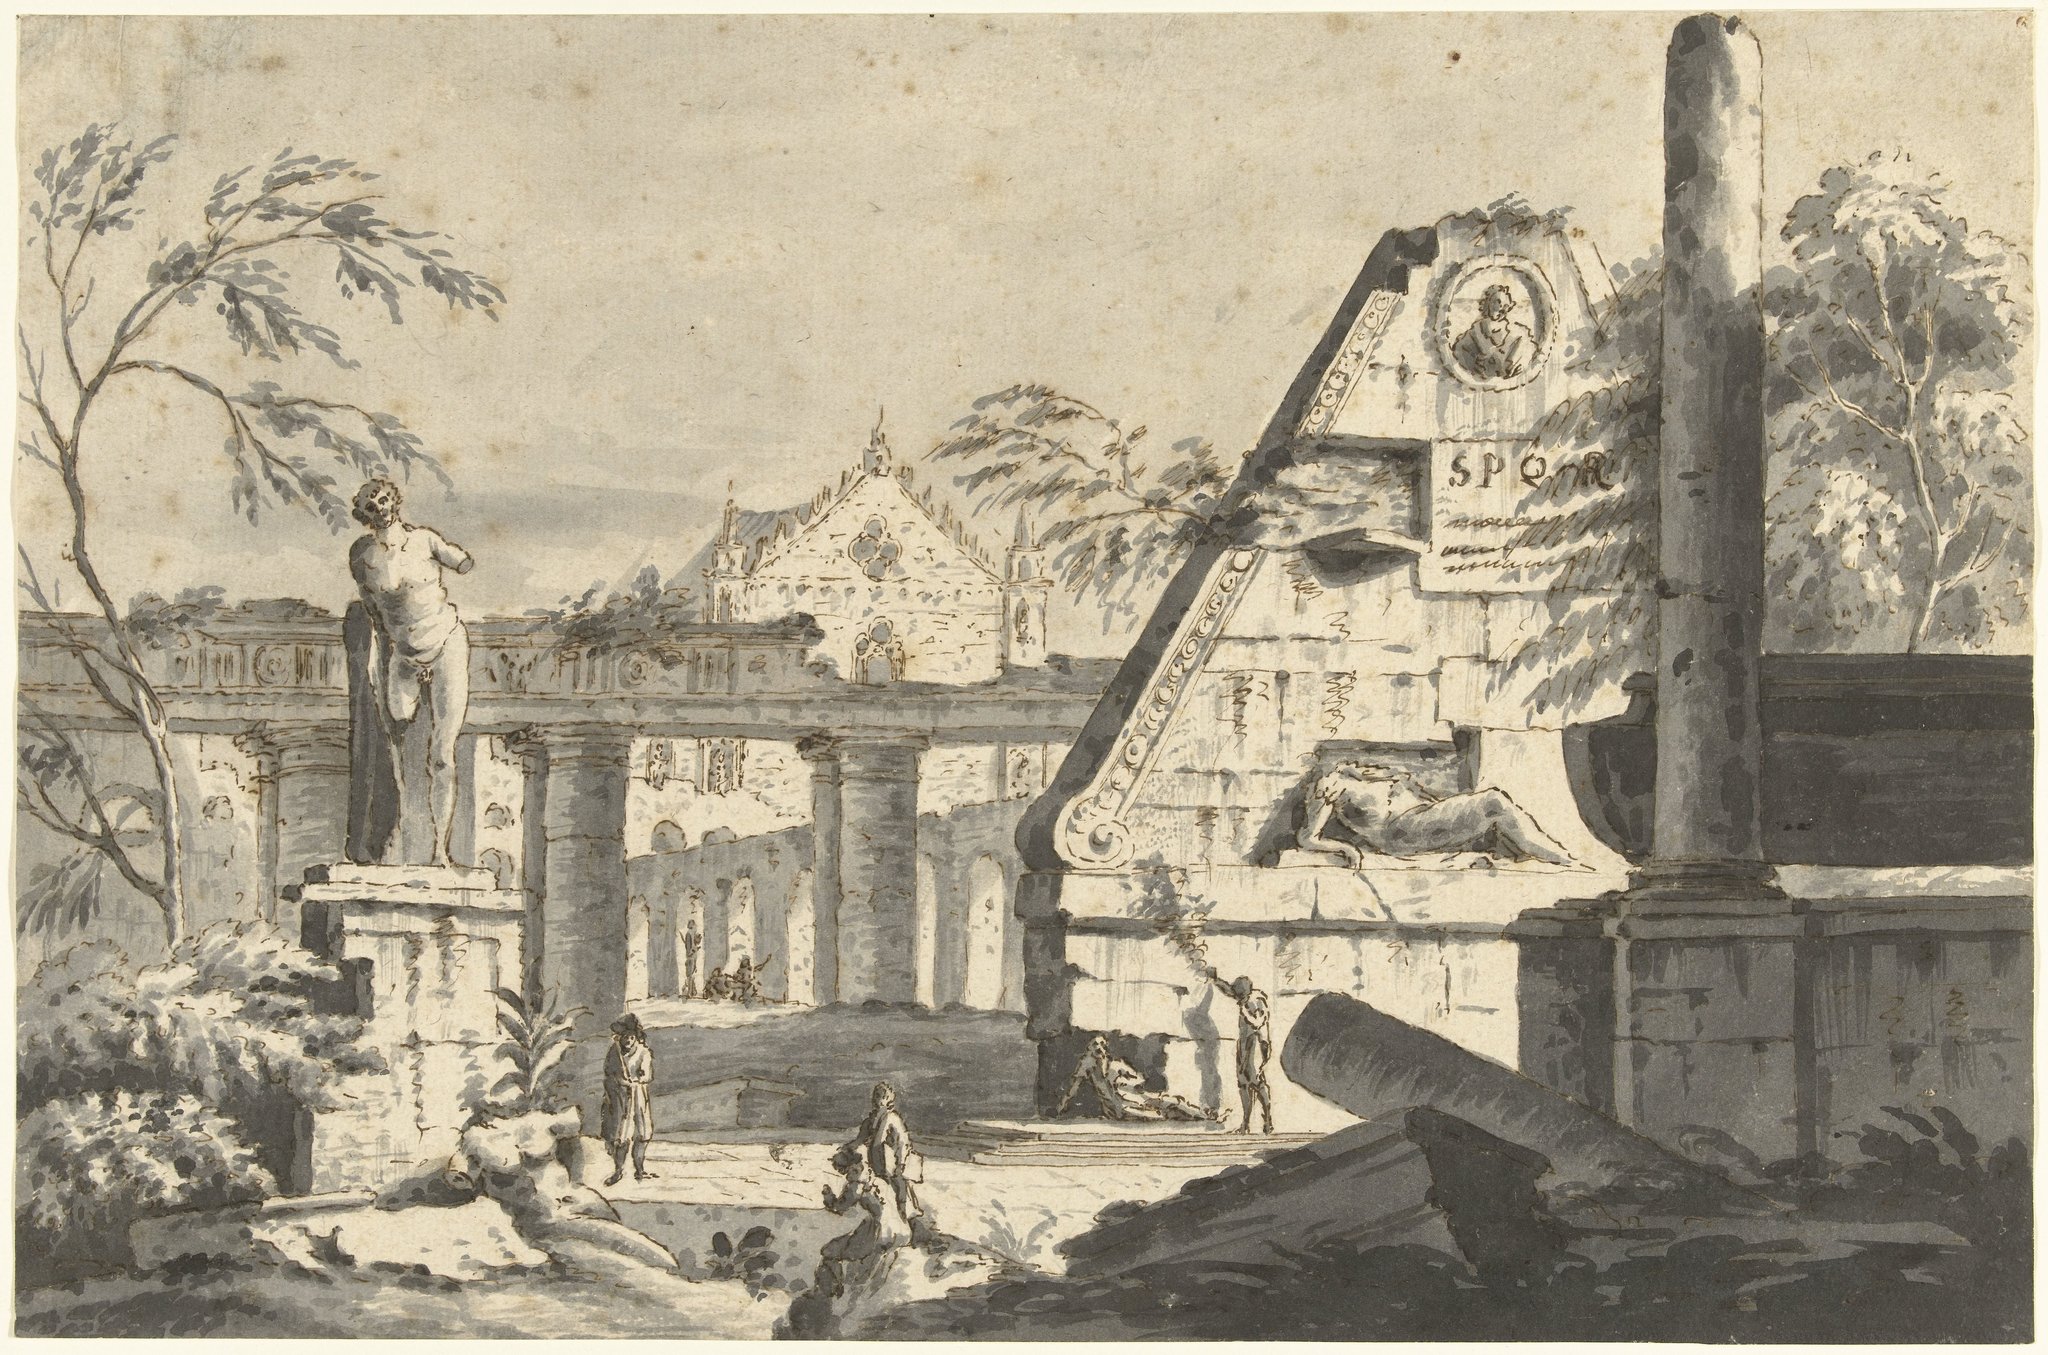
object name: drawing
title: Landschap met antieke ruïnes van gebouwen en beelden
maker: marco ricci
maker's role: draughtsman, painter, print maker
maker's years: 1676-1730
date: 1701-1765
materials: ink, paper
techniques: brush, pen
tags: ruin of a building ~ architecture (+ roman art), landscape with ruins, fantastic architecture, unrealistic architectural fantasies (+ roman art)